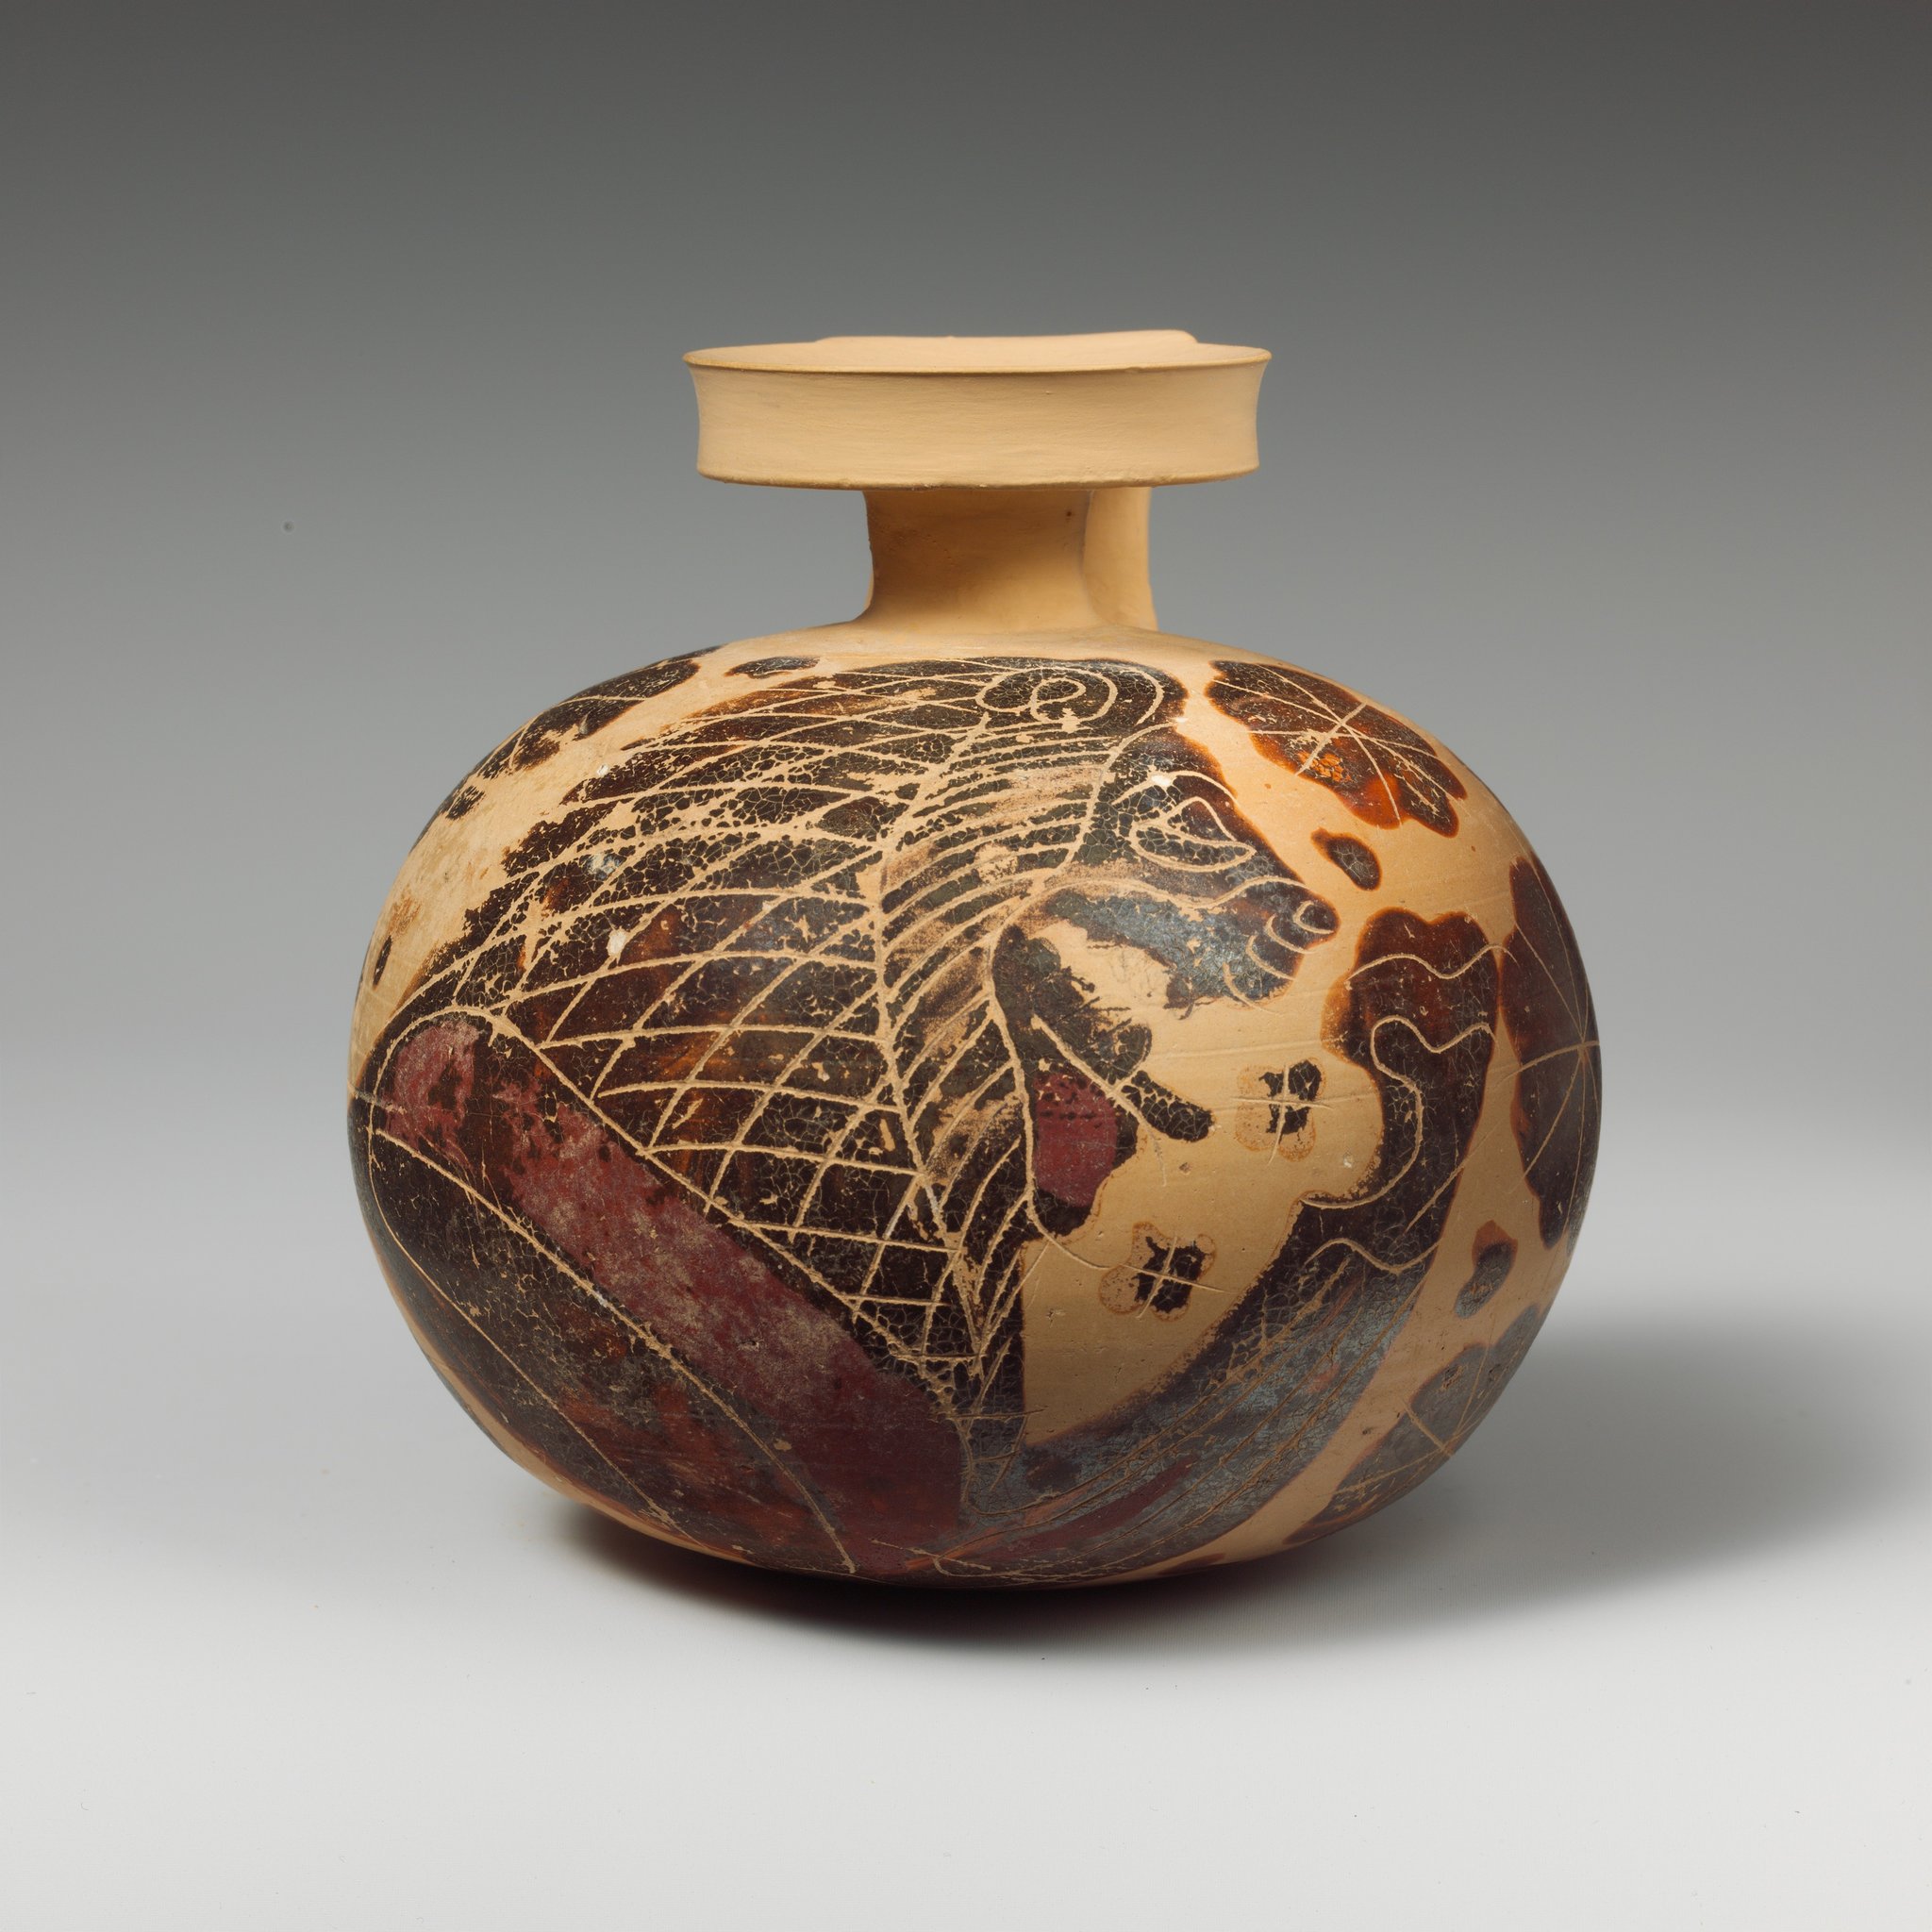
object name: aryballos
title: Terracotta aryballos (oil flask)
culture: greek, corinthian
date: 620-590 BCE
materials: terracotta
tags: lions